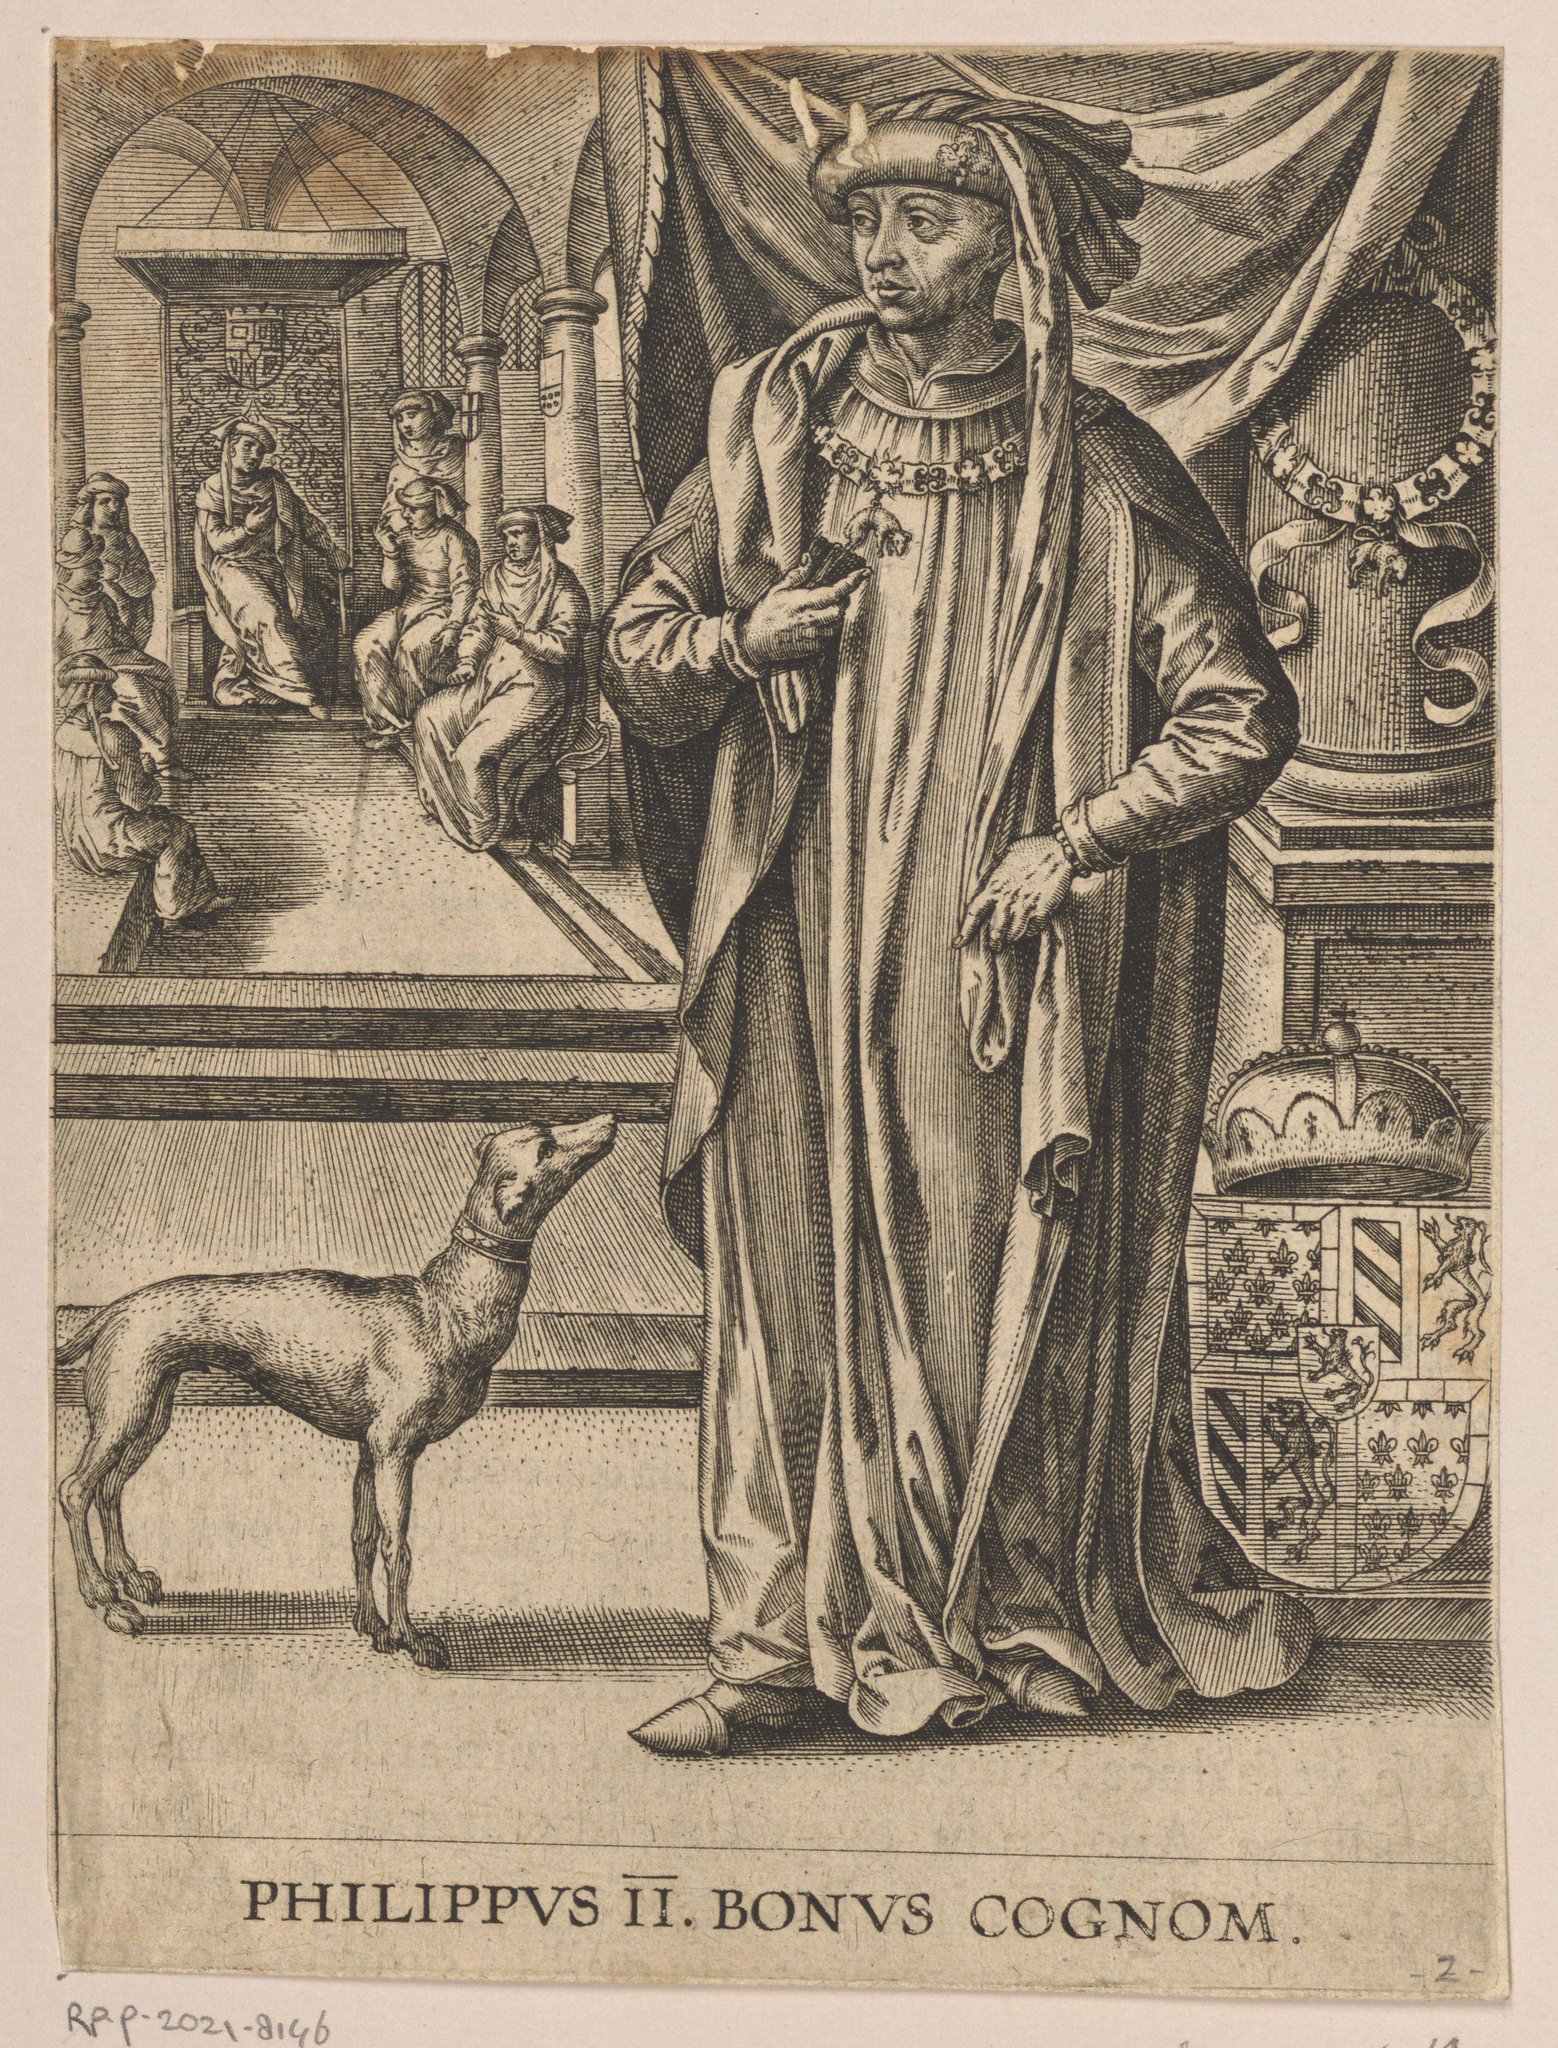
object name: print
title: Portret van Filips de Goede, hertog van Bourgondië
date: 1600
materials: paper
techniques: engraving, letterpress printing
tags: bruges, philip iii the good, historical persons, knighthood order of the golden fleece, armorial bearing, heraldry, dog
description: Prent uit: Barlandus, Hadrianus Cornelli. Ducum Brabantiae Chronica. Antwerpen: Johannes Moretus, 1600.